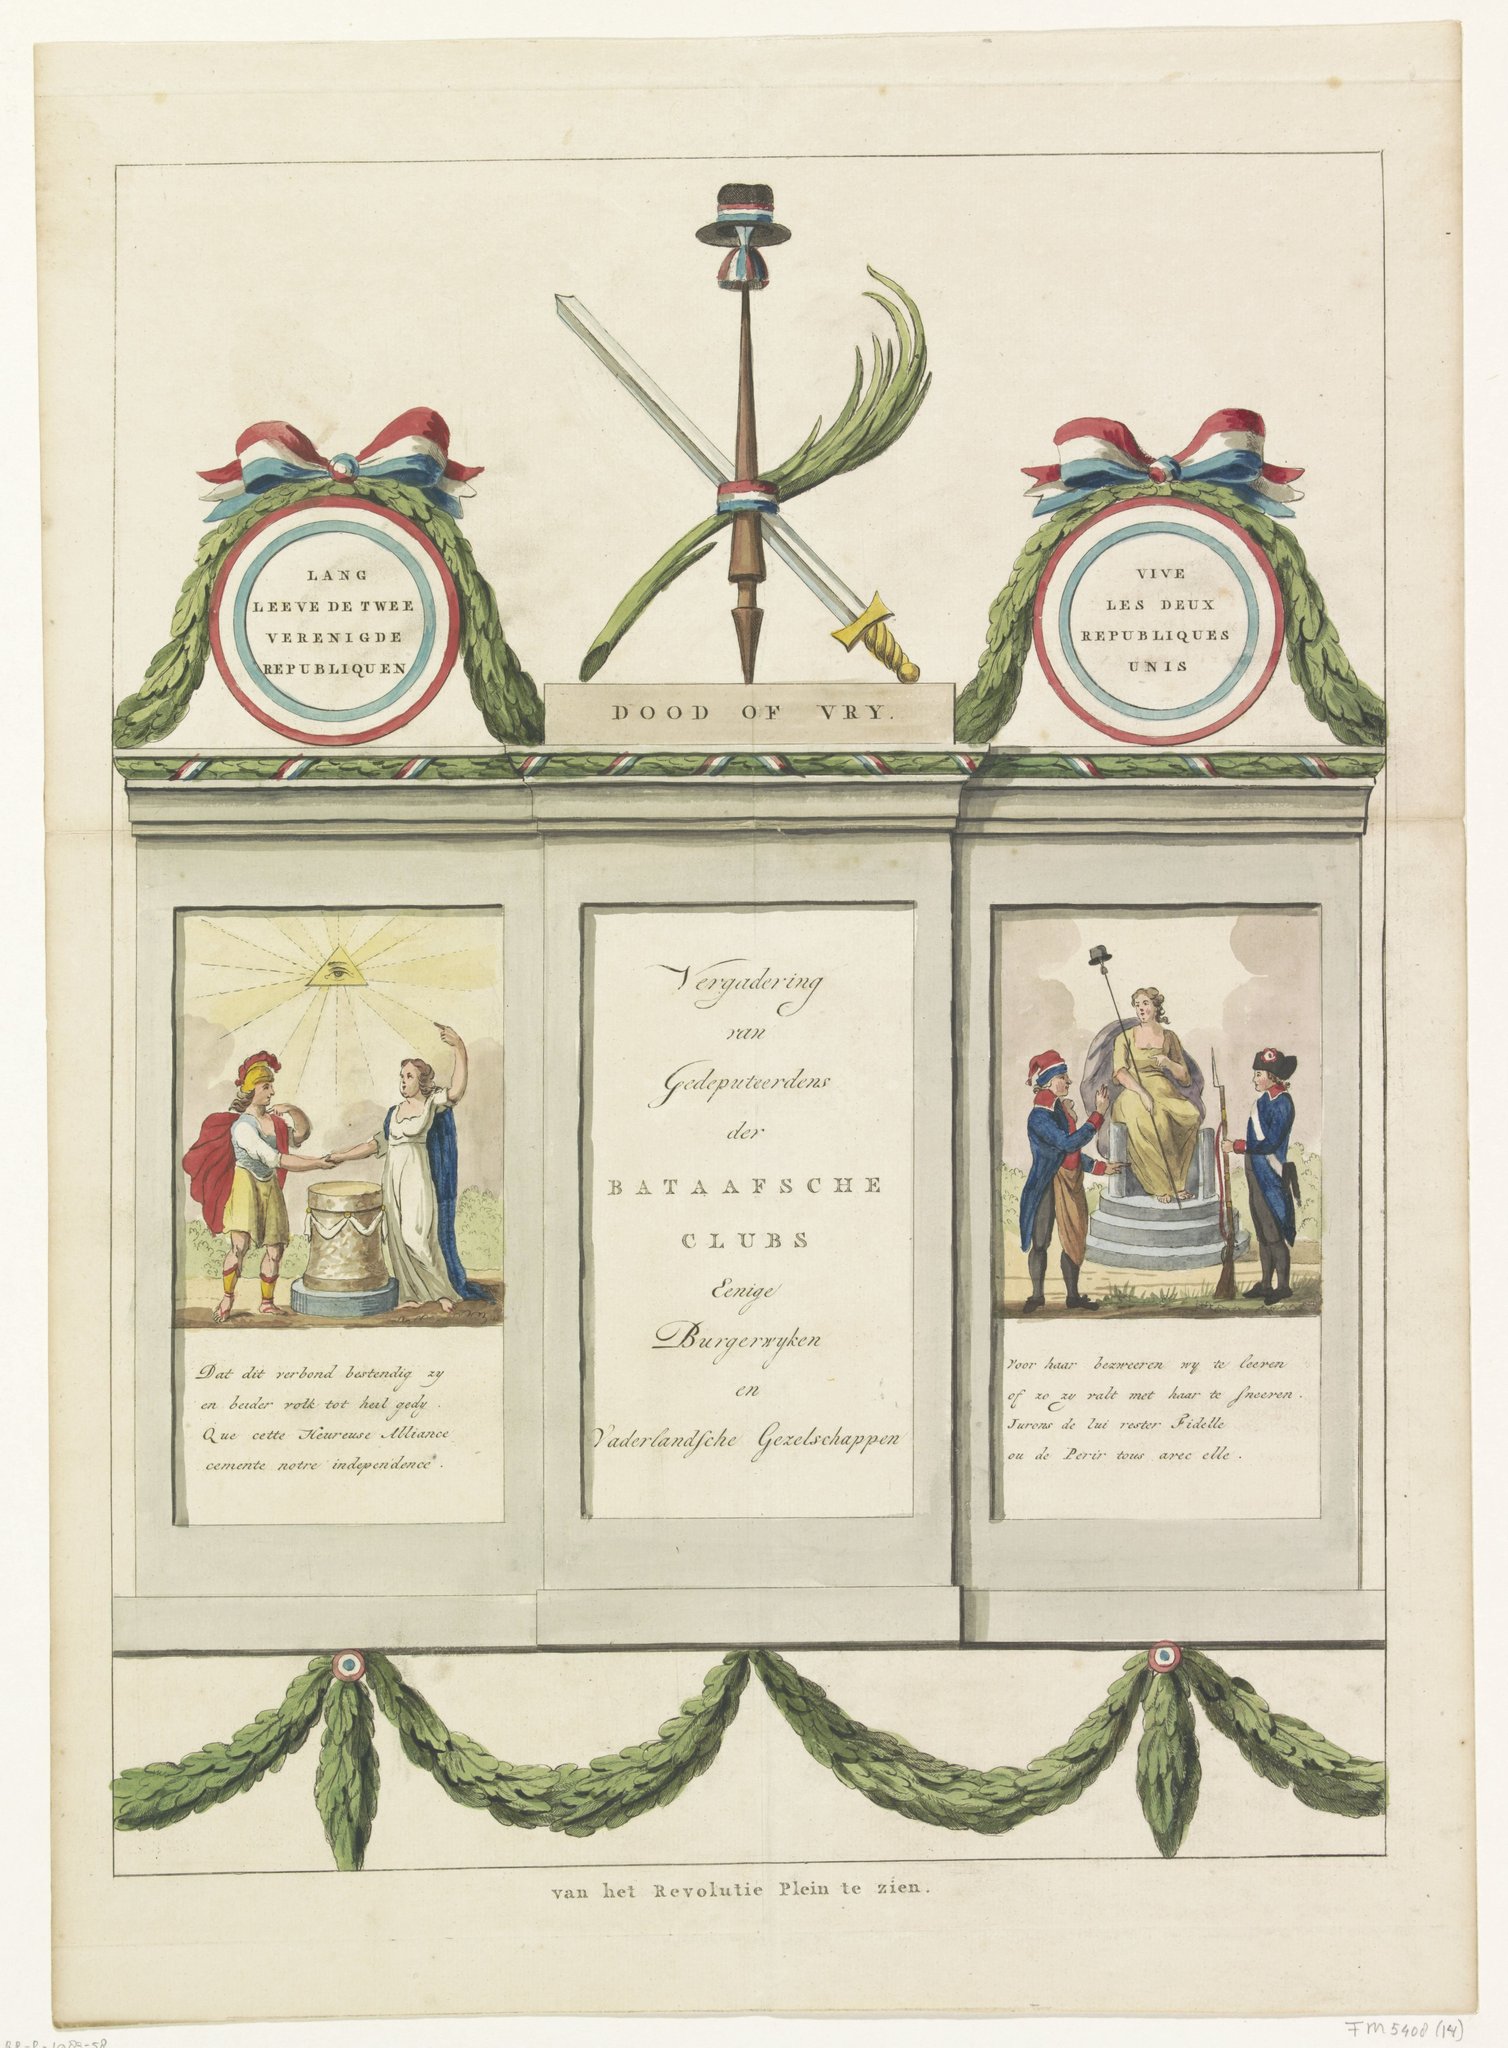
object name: print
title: Decoratie in de Beurssteeg, 1795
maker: Anonymous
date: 1795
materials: paper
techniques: etching, hand coloring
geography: netherlands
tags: freedom, liberty; 'libertà' (ripa) (+ abstract concept represented by female figure), festivities on events of national importance (+ festive decoration ~ festive activities), alliance, league, union, foedus, amsterdam, alliance with france (1795)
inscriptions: collector's mark: Lugt 2228, collector's mark: Lugt 2760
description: Decoratie in de Beurssteeg, gezien vanaf de Dam, 1795. Opgericht door een Vergadering van Gedeputeerden van de Bataafsche Clubs, Burgerwijken en Vaderlandsche Gezelschappen te Amsterdam bij het Alliantiefeest op 19 juni 1795. Op de twee chassinetten allegorieën van het Verbond en van de Vrijheid, elk met een vierregelig vers.